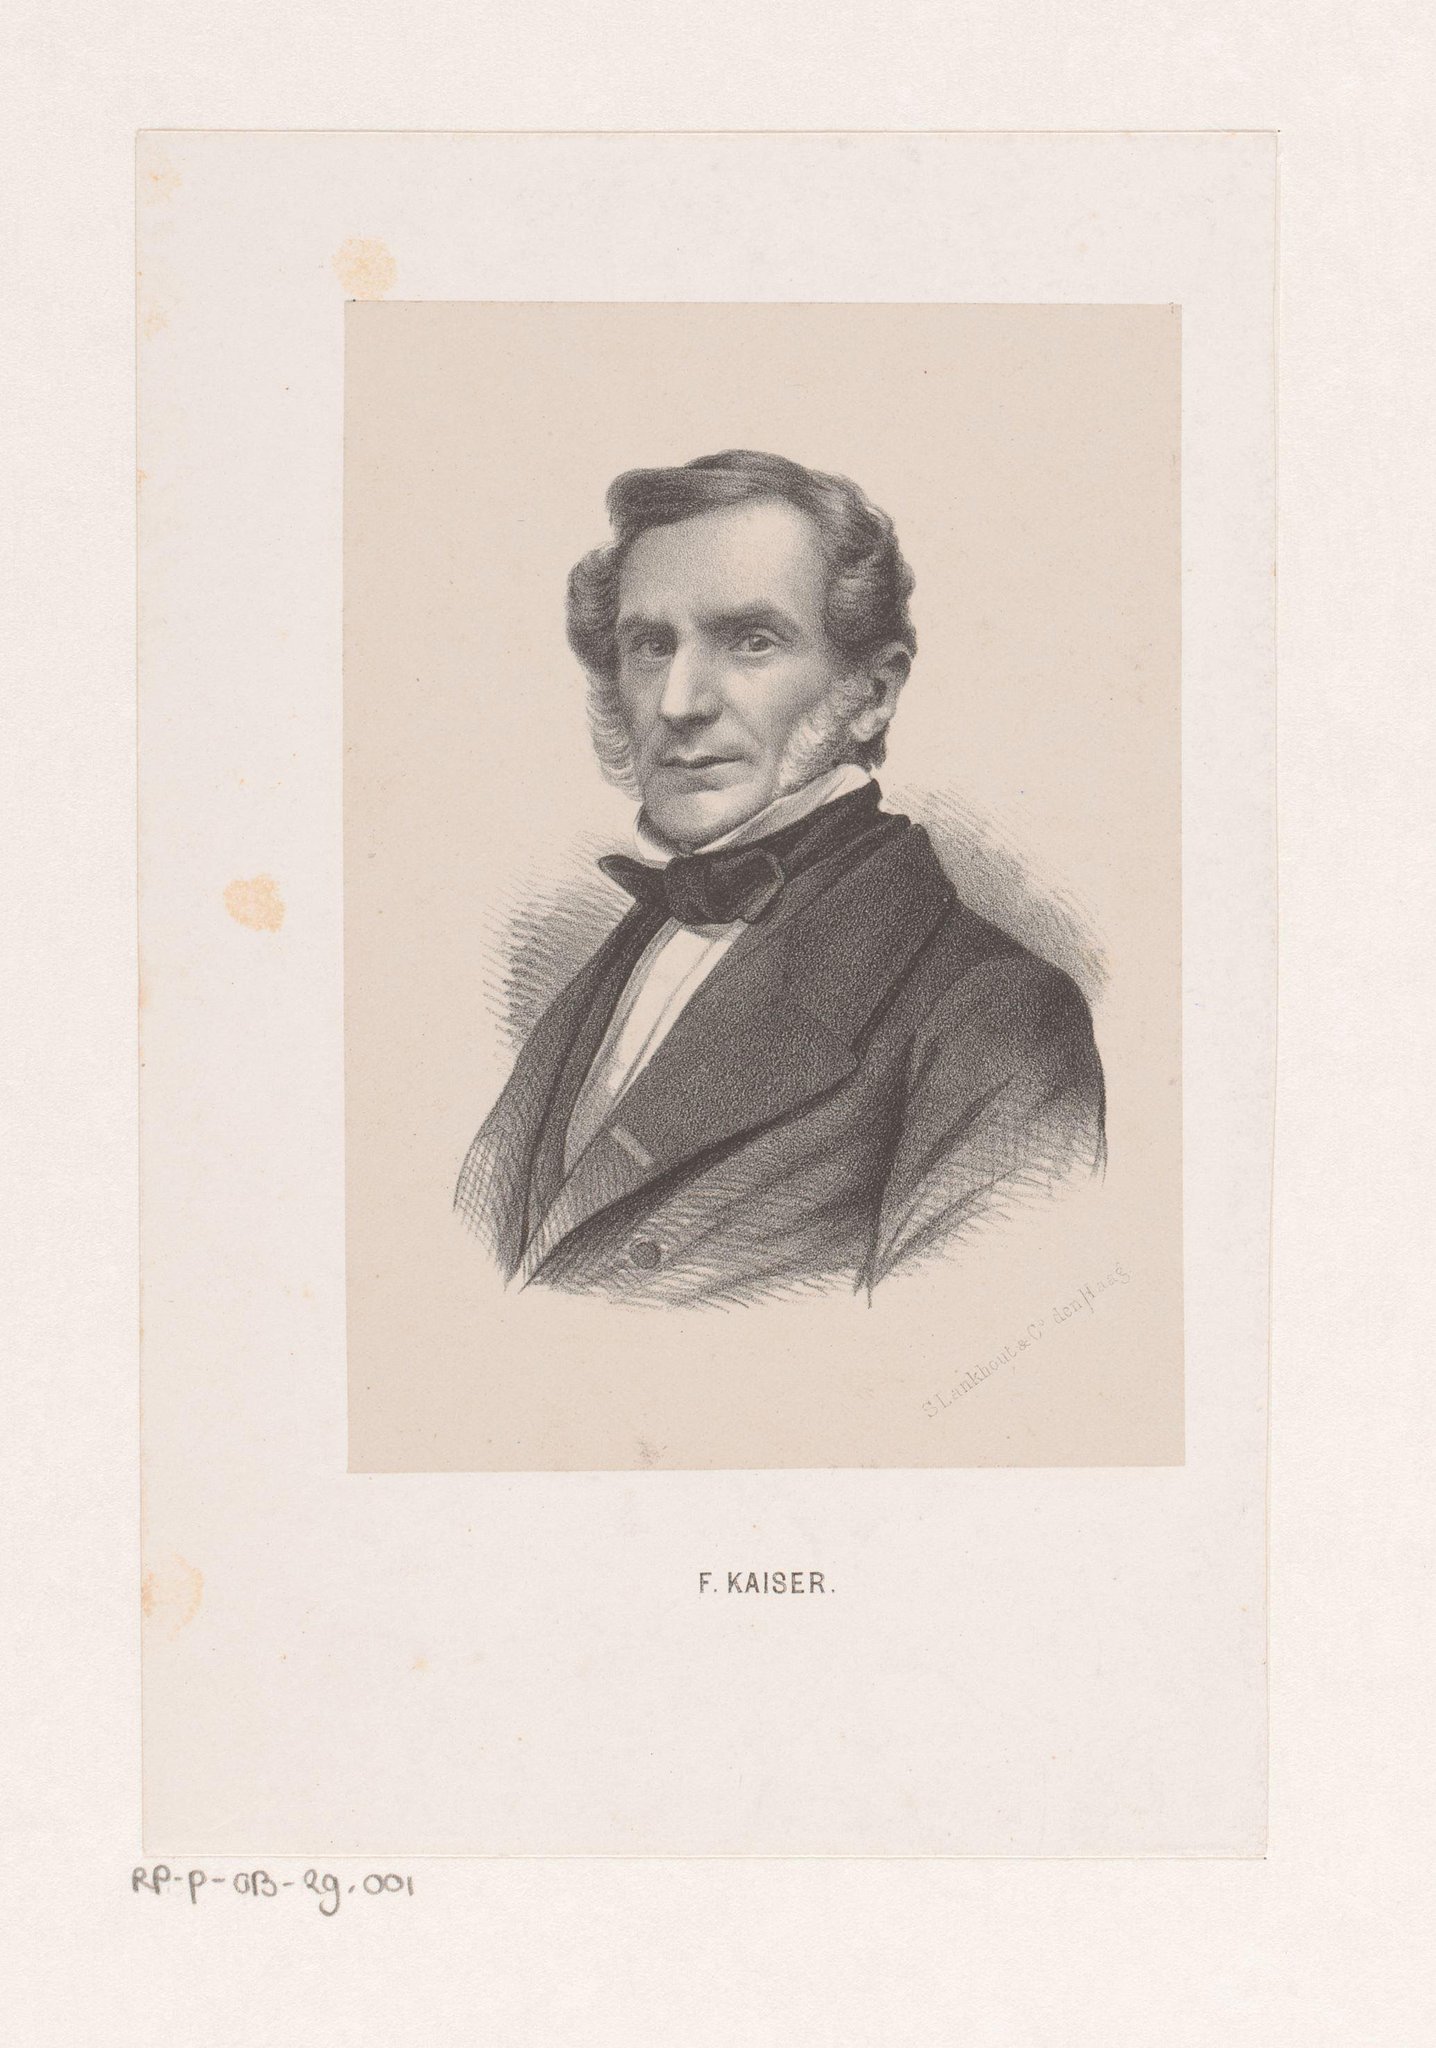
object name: print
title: Portret van Frederik Kaiser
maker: Anonymous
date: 1877-1903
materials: paper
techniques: lithograph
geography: the hague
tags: historical persons (+ (full) bust portrait)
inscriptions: collector's mark: Lugt 2228